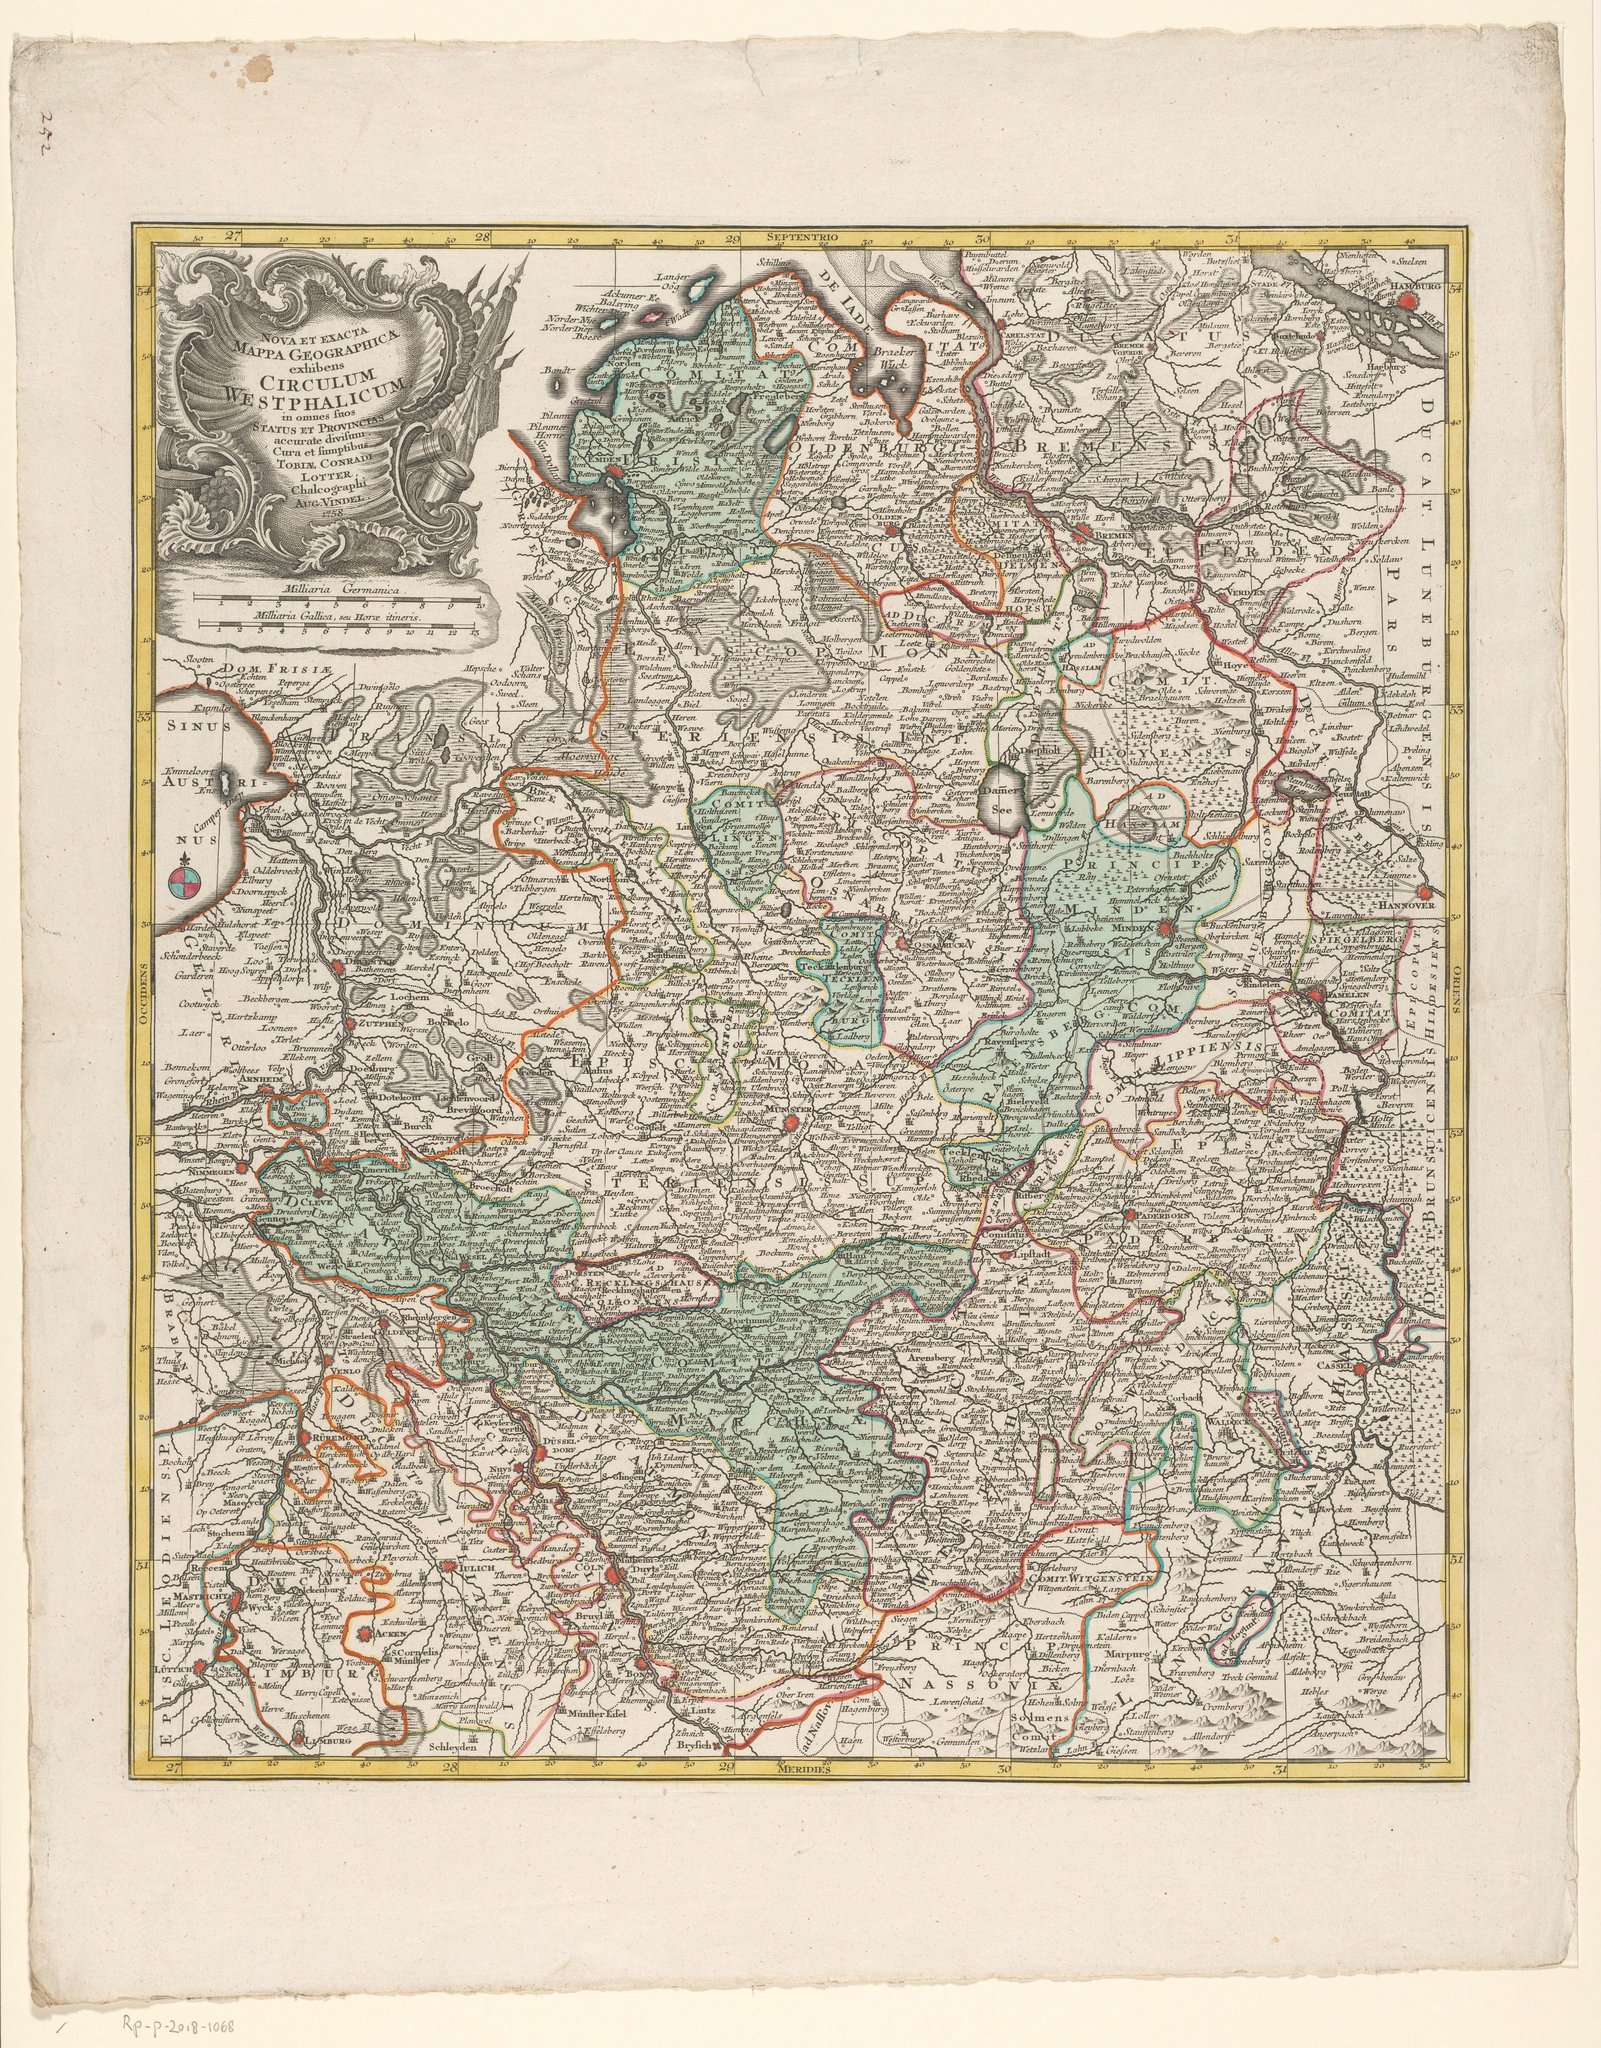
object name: map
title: Kaart van Westfalen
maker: tobias conrad lotter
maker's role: publisher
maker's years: 1717-1777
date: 1758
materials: paper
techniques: engraving, hand coloring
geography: augsburg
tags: maps of separate countries or regions, germany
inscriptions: collector's mark: Lugt 2228